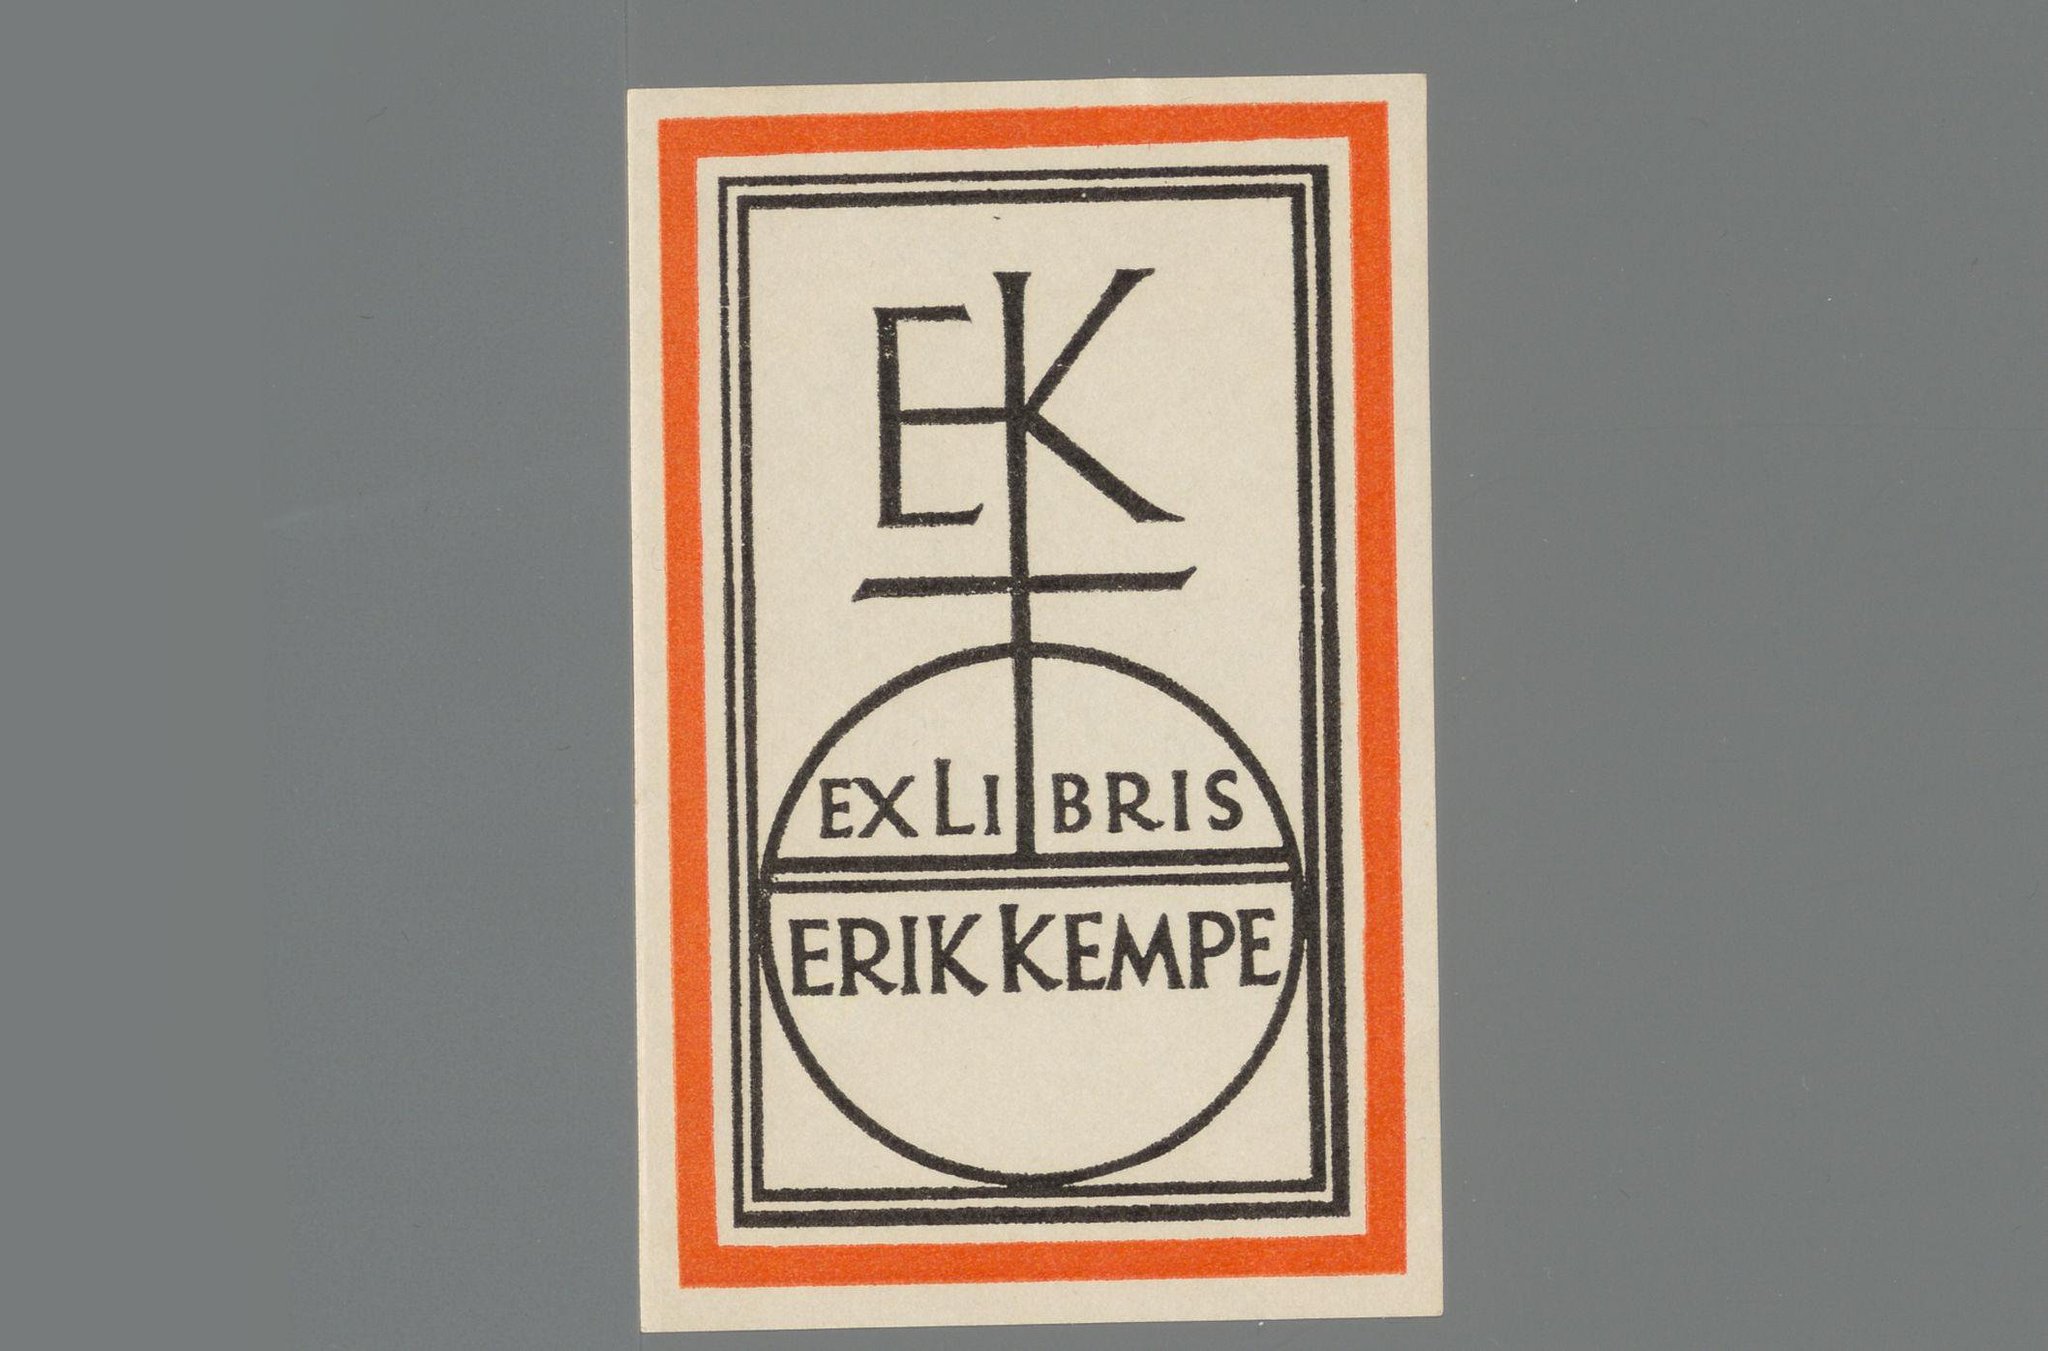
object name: bookplate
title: Ex libris van Erik Kempe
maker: Anonymous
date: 1938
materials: paper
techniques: printing block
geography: germany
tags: the cross ~ symbols of christ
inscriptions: inscription: ‘Fil. Dr. Ösnkölarich (?) / Rudolf / Steiner-Prag / 1938’